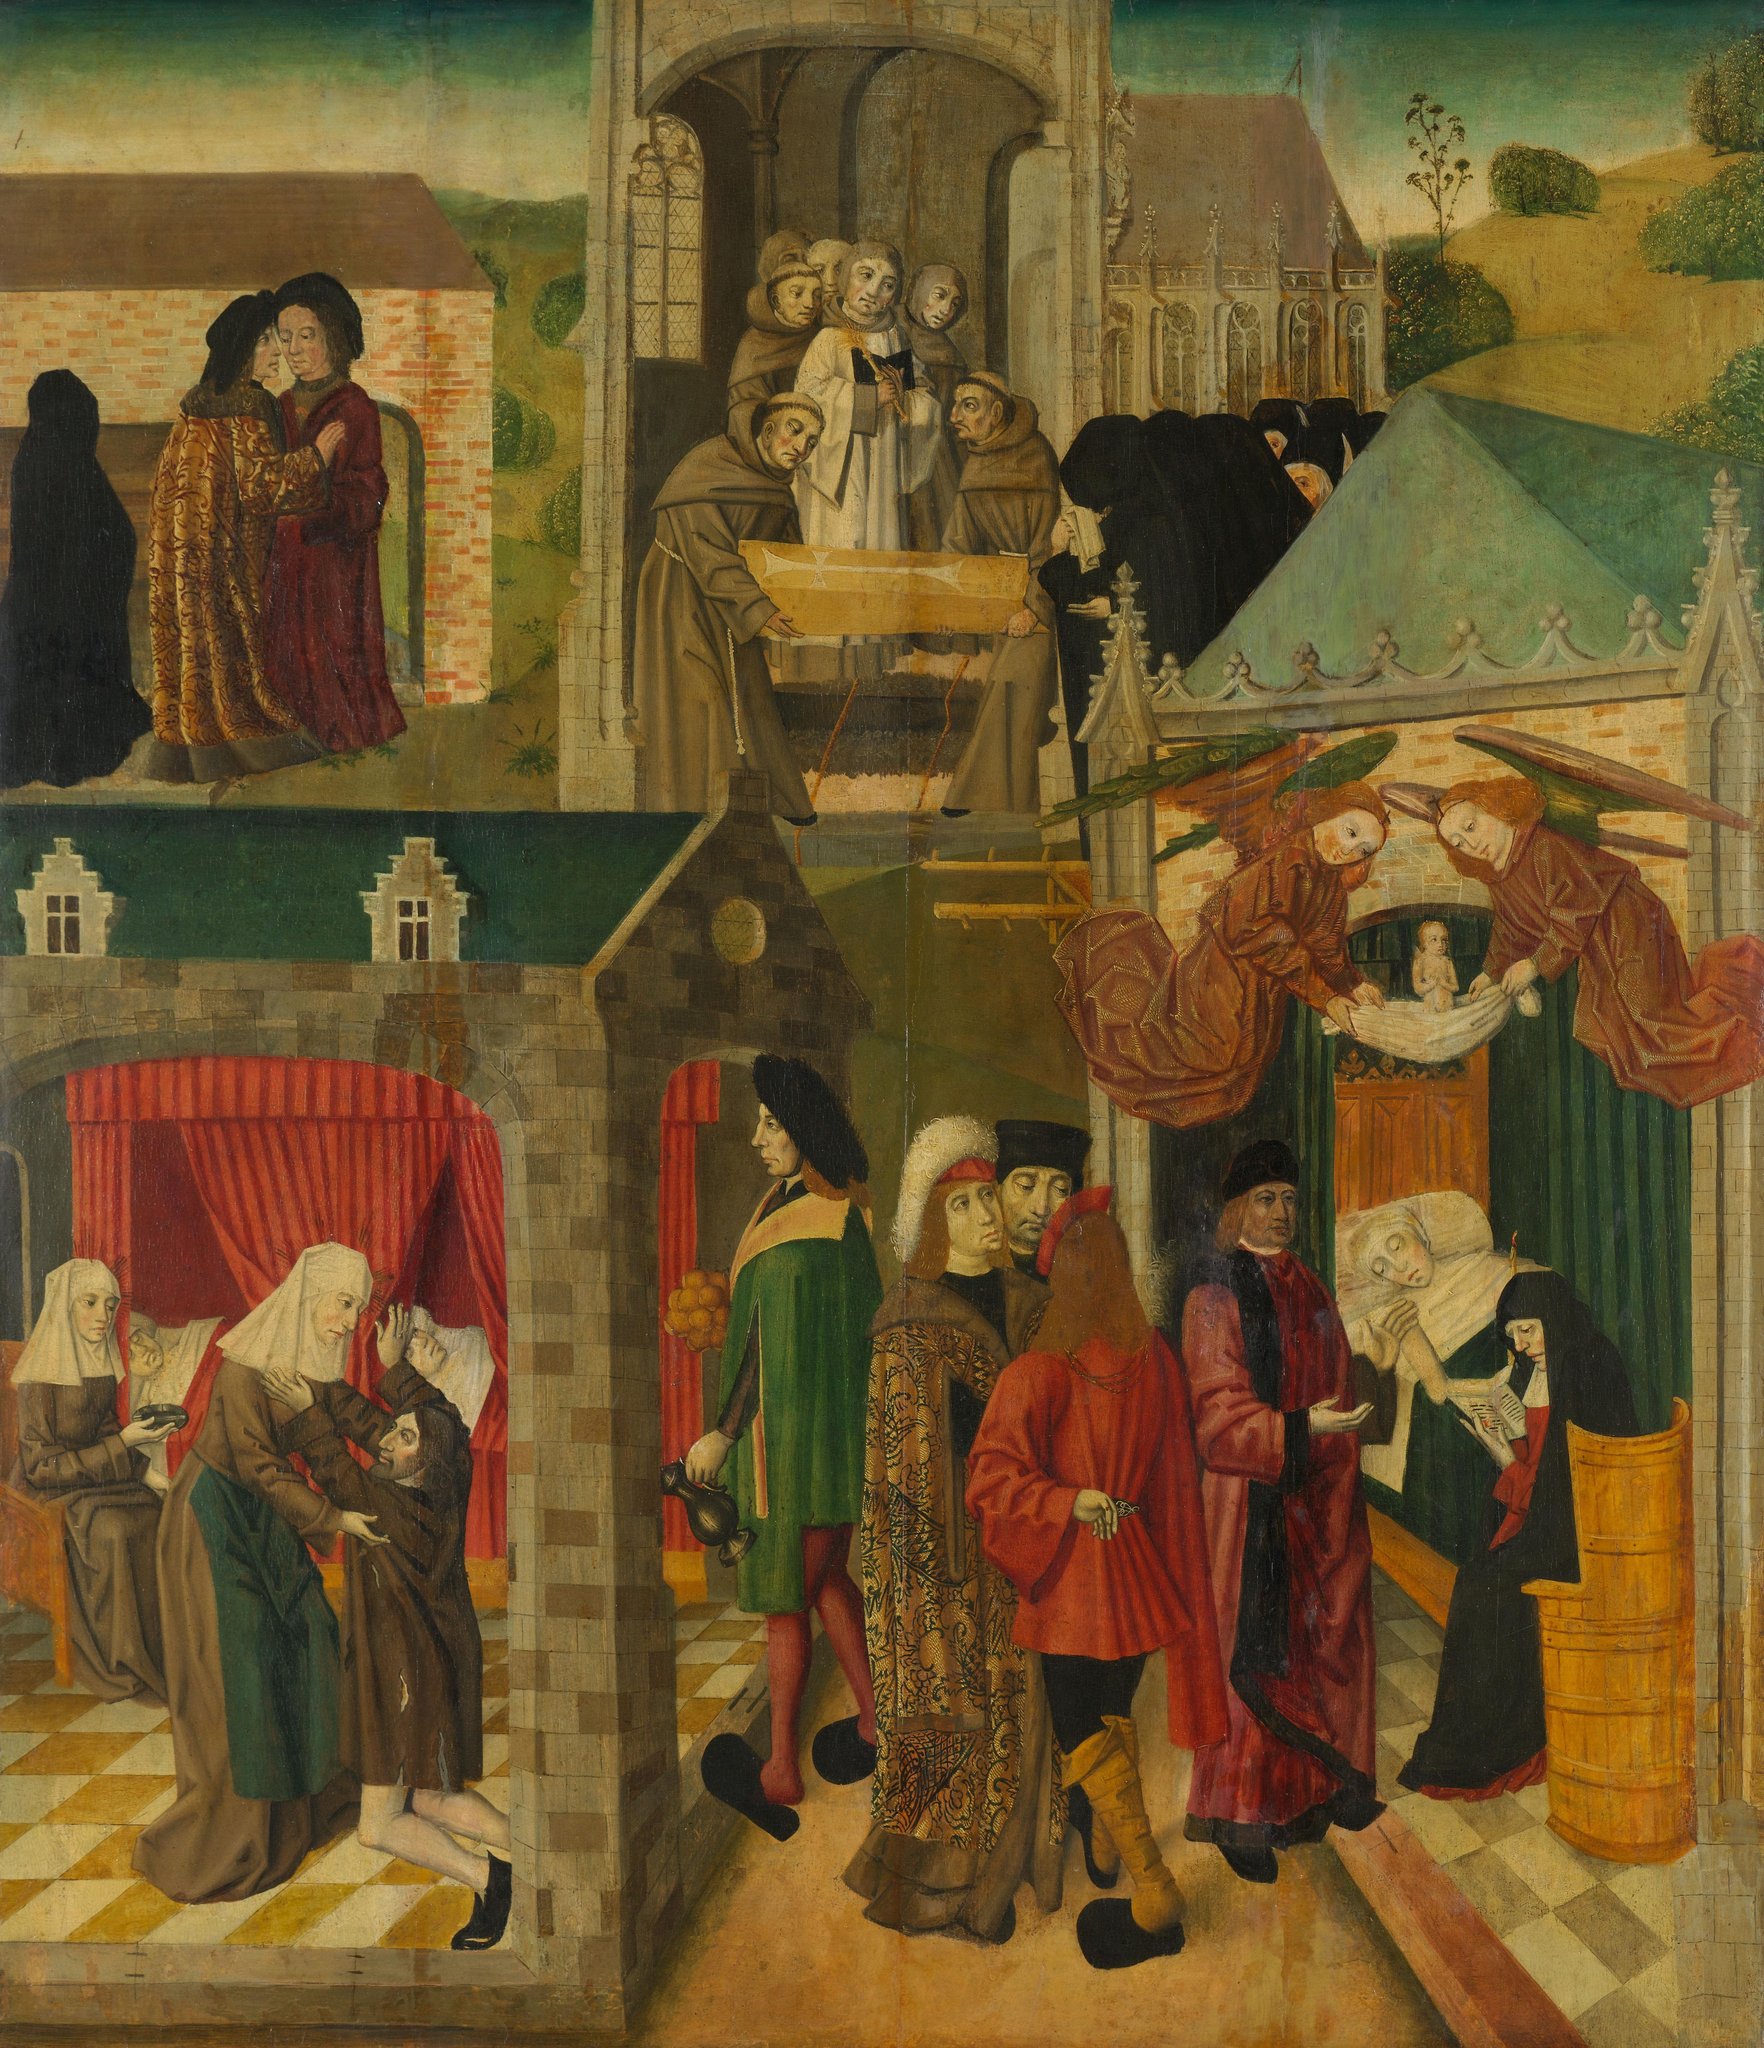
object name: painting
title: Saint Elizabeth of Hungary Tending the Sick in Marburg, Death of St Elizabeth, inner right wing of an altarpiece made for the Grote Kerk in Dordrecht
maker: master of the st elizabeth panels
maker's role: painter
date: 1490-1495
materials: oil, panel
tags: the wife and widow of the landgrave of thuringia, and franciscan tertiary, elisabeth of hungary; possible attributes: beggar, cripple, fish, loaves, leper, model of church, pitcher, roses in lap, scald-head, three crowns, nursing, tending the sick, visiting the sick; sick person together with others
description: Scènes uit het leven van de heilige Elisabeth van Hongarije (1207-31). Links op de achtergrond: Lodewijk vertrouwt voor zijn vertrek naar het Heilige Land Elisabeth toe aan zijn zwager. Links op de voorgrond: Elisabeth, na de dood van Lodewijk in 1227 uit de Wartburg verdreven, ontvangt in het door haar gestichte ziekenhuis te Marburg een gewonde man en verpleegt de zieken. Rechts Elisabeth op haar sterfbed bijgestaan door Meester Koenraad en een biddende non. Twee engelen dragen haar ziel naar de hemel. Boven wordt de heilige door twee Franciscaner monniken begraven. Binnenzijde van het rechterpaneel, maakt deel uit van twee panelen, aan weerszijden beschilderd met voorstellingen uit het leven van de heilige Elisabeth van Hongarije (1207-31) en de Sint Elisabethsvloed 18-19 november 1421 (SK-A-3145/46 en SK-A-3147A/B).